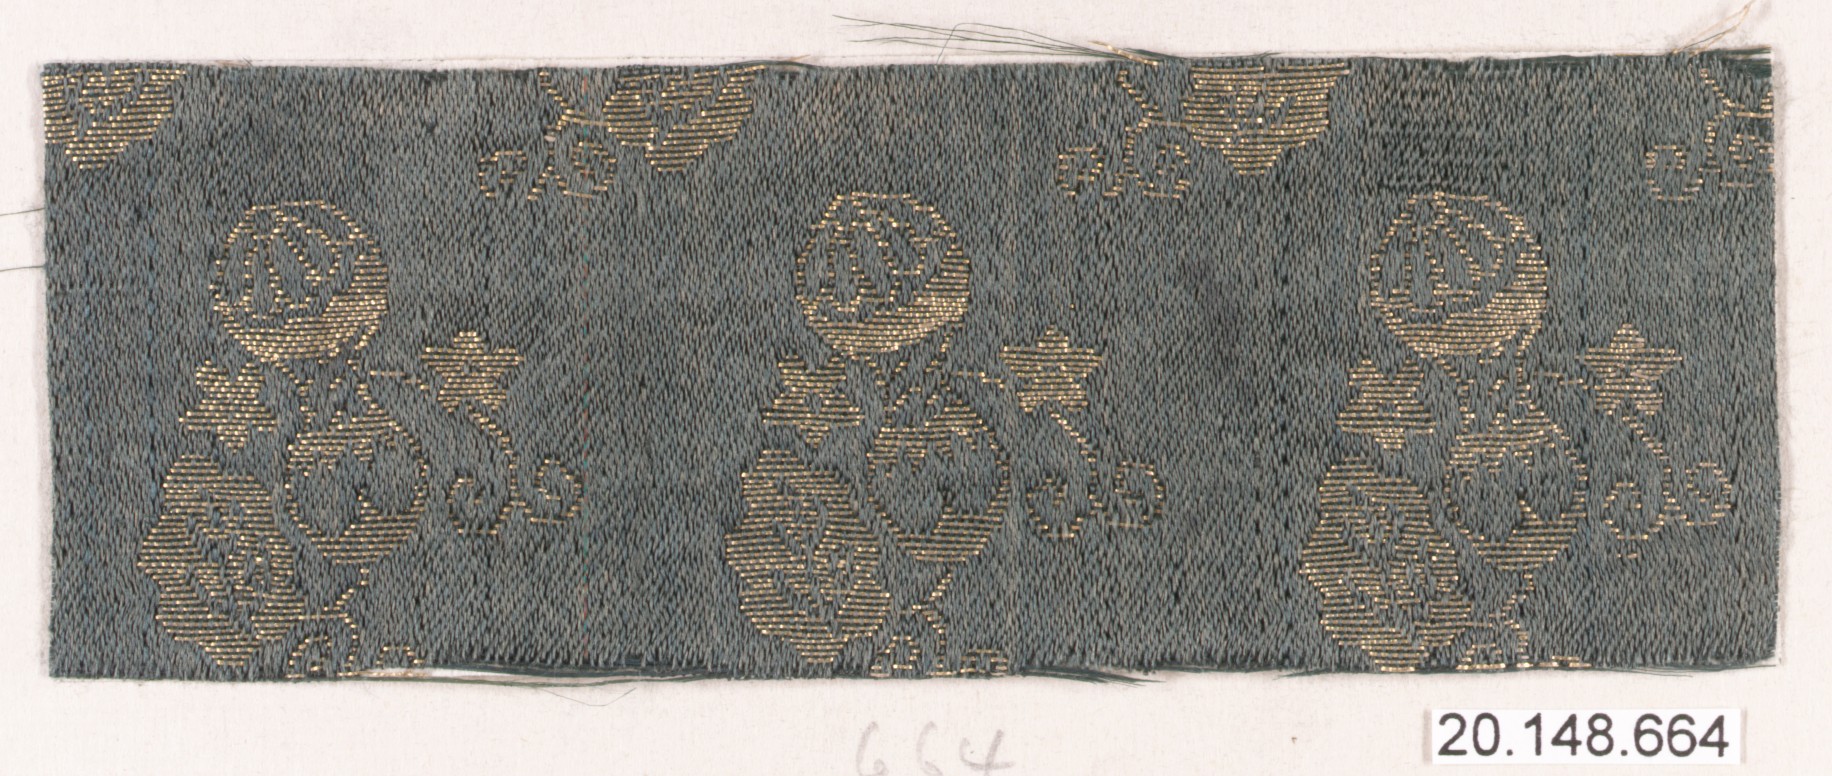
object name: piece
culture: japanese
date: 1701-1800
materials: silk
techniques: compound weave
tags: flowers,leaves